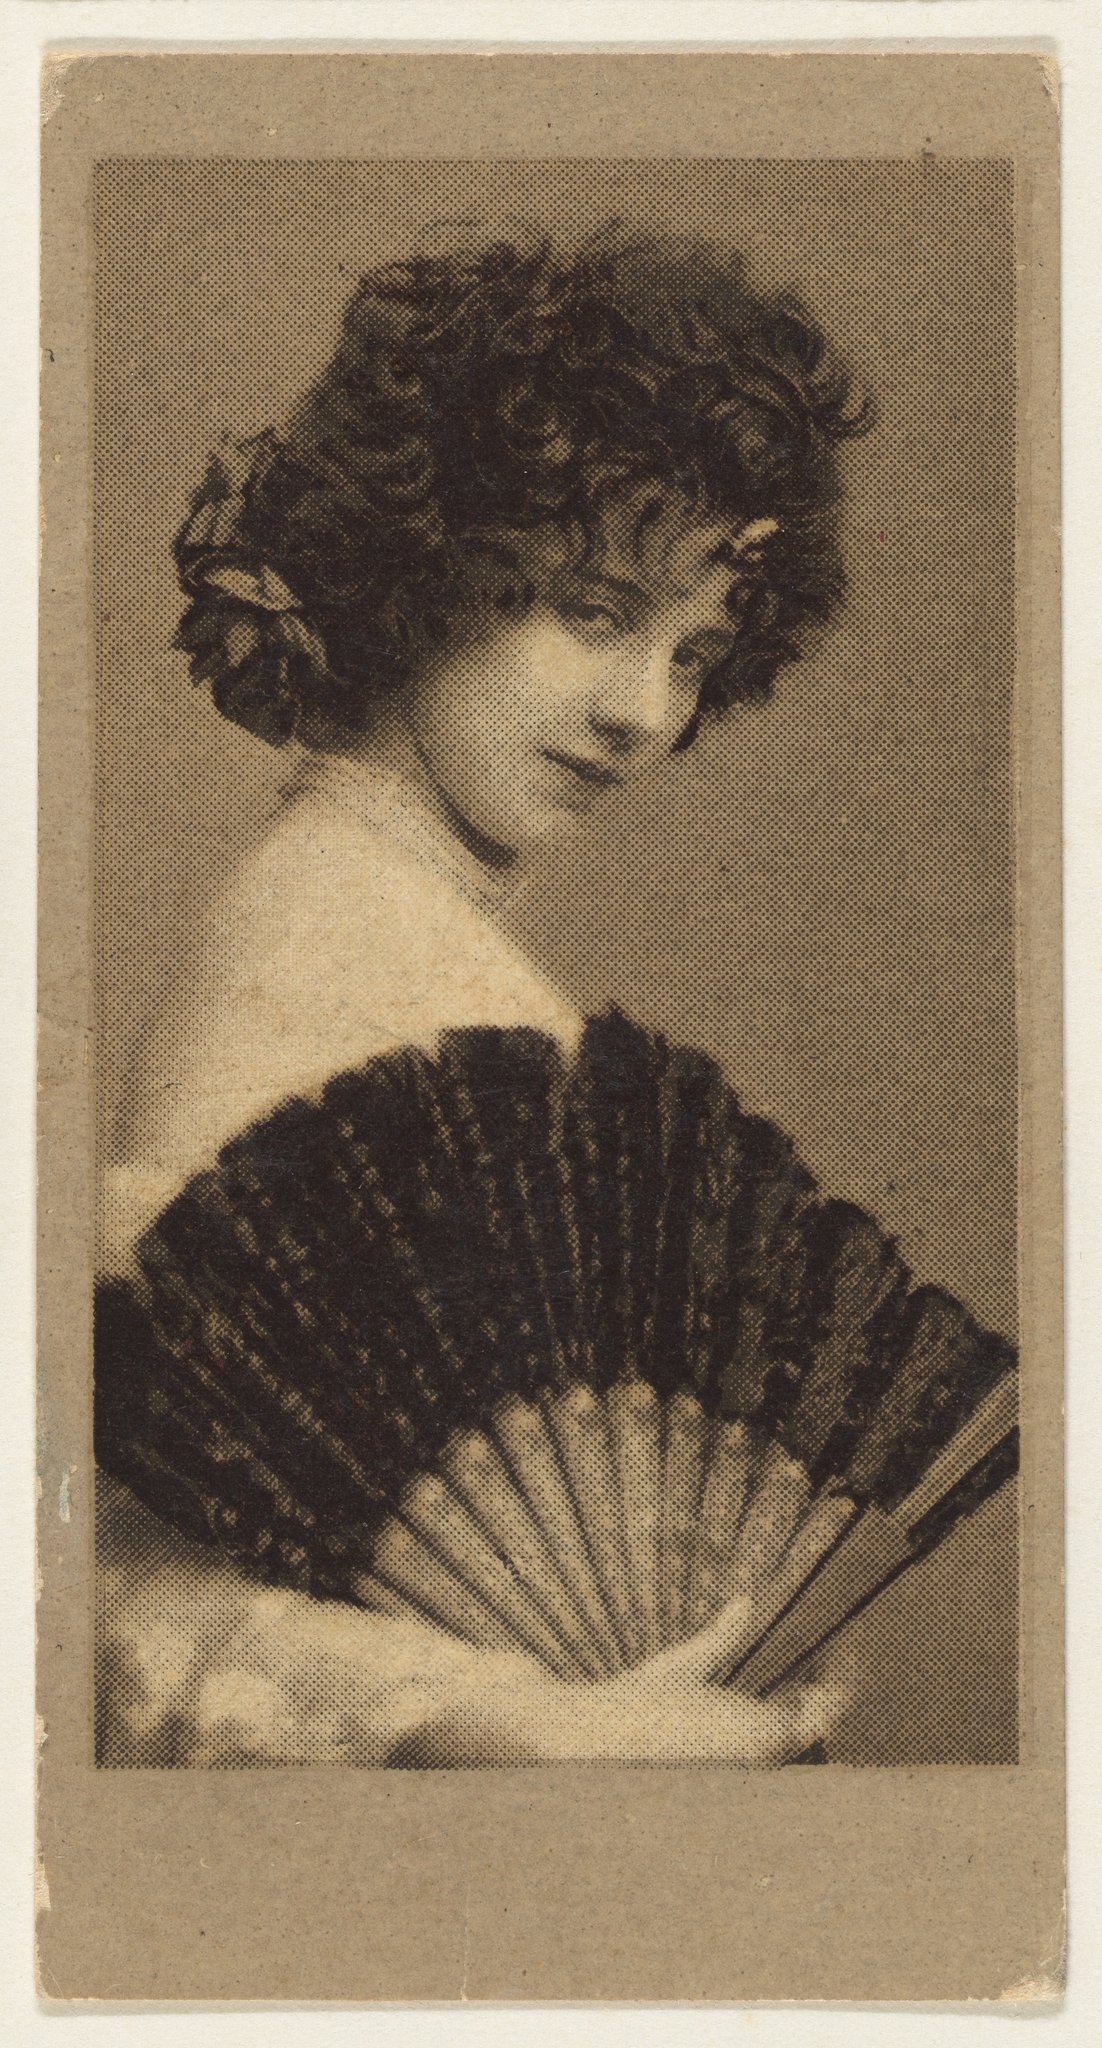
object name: print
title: Portrait of a woman holding a fan, from the "Girls" series (T66), issued with Hunter Dog Cigarros by S. Monday & Sons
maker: s. monday & sons, brooklyn, new york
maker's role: publisher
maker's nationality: american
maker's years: 1850-1950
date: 1900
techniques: photolithograph